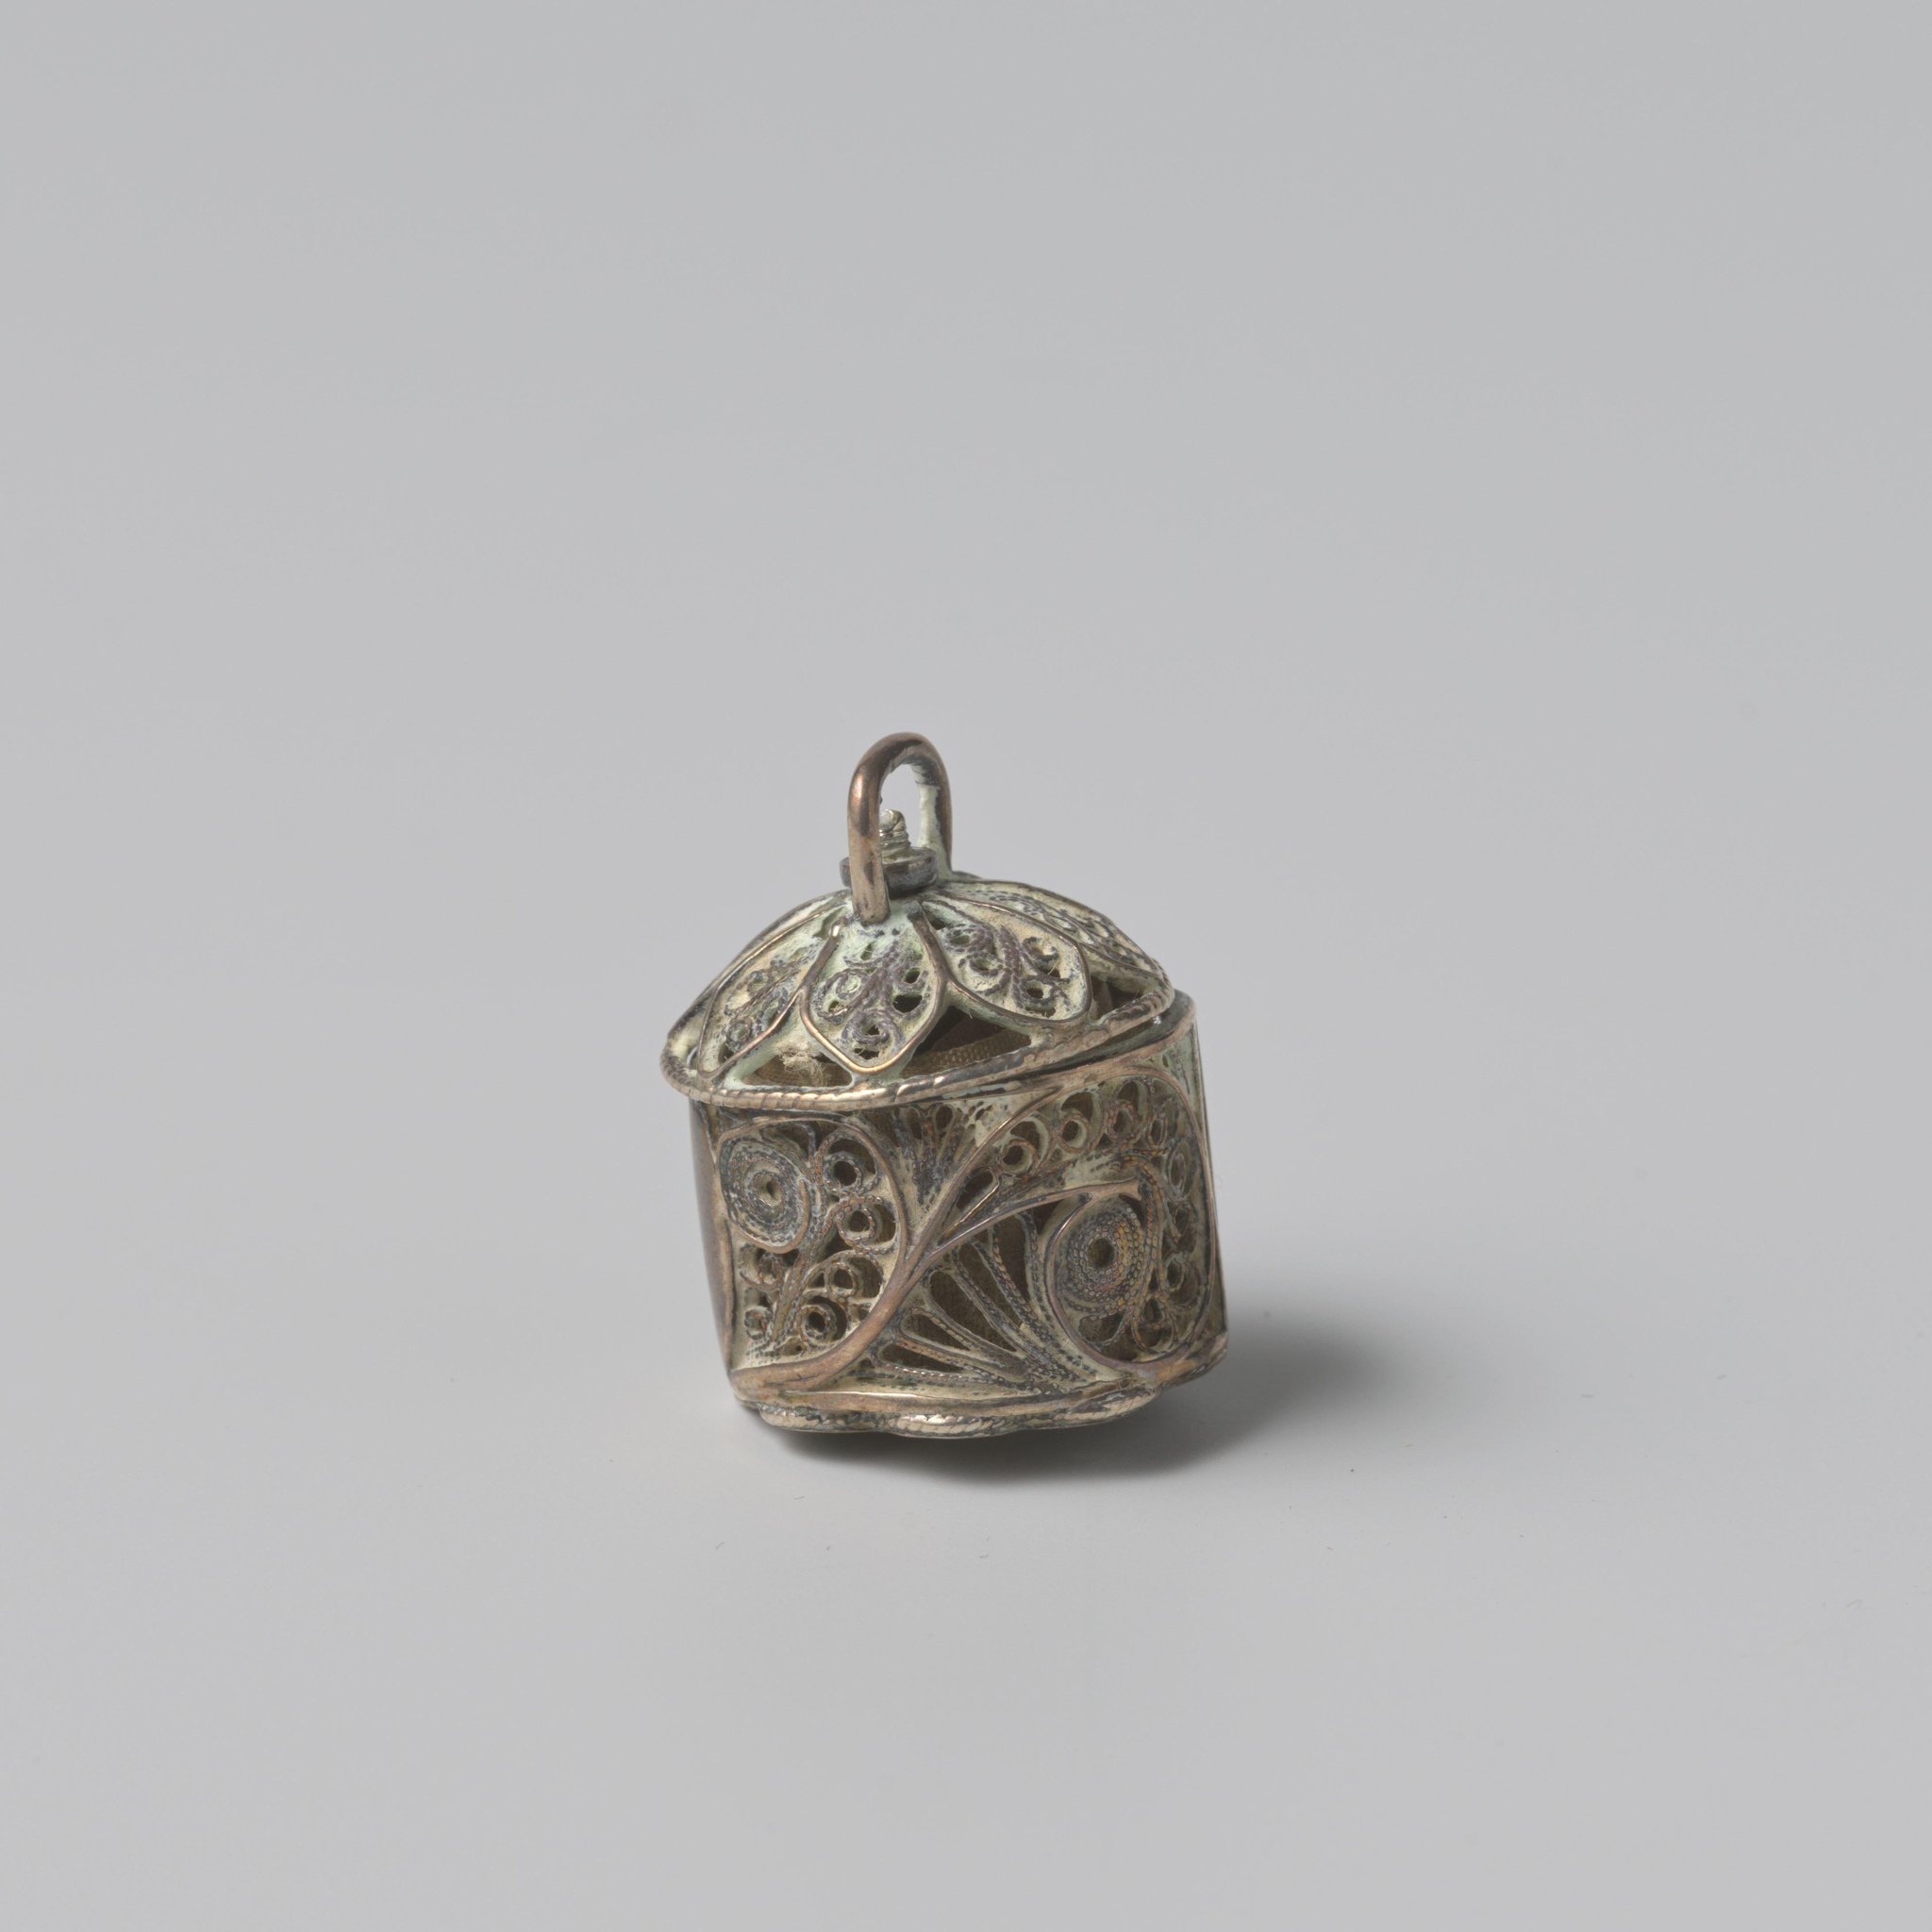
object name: tape measure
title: Meetlint, 'centimeter', van filigrein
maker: Anonymous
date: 1400-1950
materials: silver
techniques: filigree